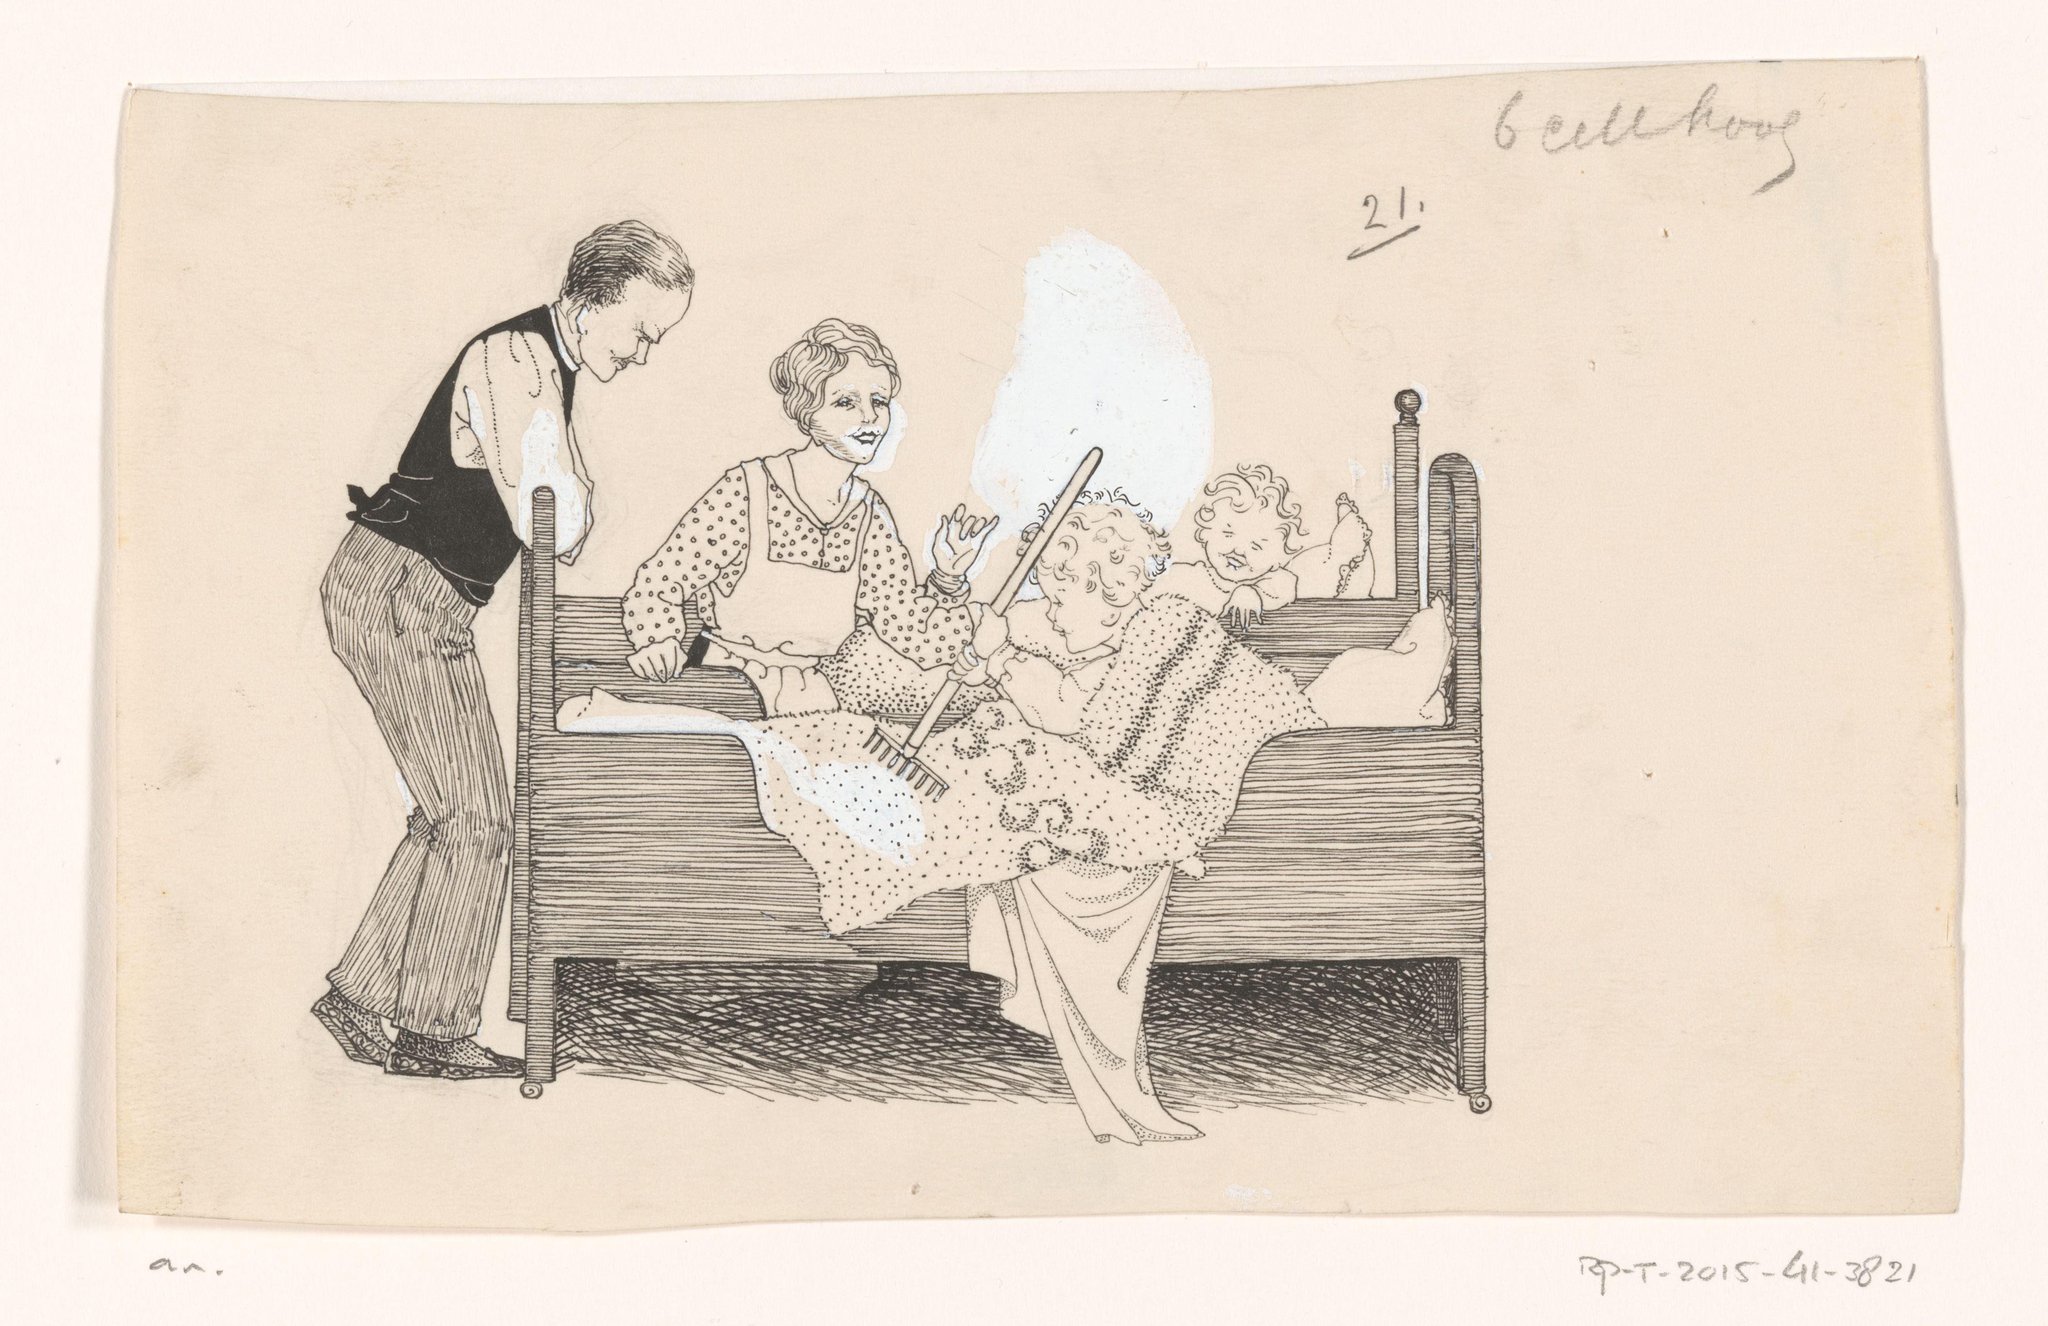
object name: boekillustratie ontwerp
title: Kind met hark in een bed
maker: Anonymous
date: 1890-1930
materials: paint, ink, paper, pencil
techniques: brush, pen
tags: parents with their children, bed, agricultural implements: rake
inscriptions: collector's mark: Lugt 2228a, :, number: ‘21.’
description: Een kind zit met een hark in een bed en maakt een beweging alsof de hark een peddel is om een boot (in de vorm van het bed) vooruit te bewegen. Een broertje of zusje ligt in het bed erachter en vader en moeder staan ernaast.